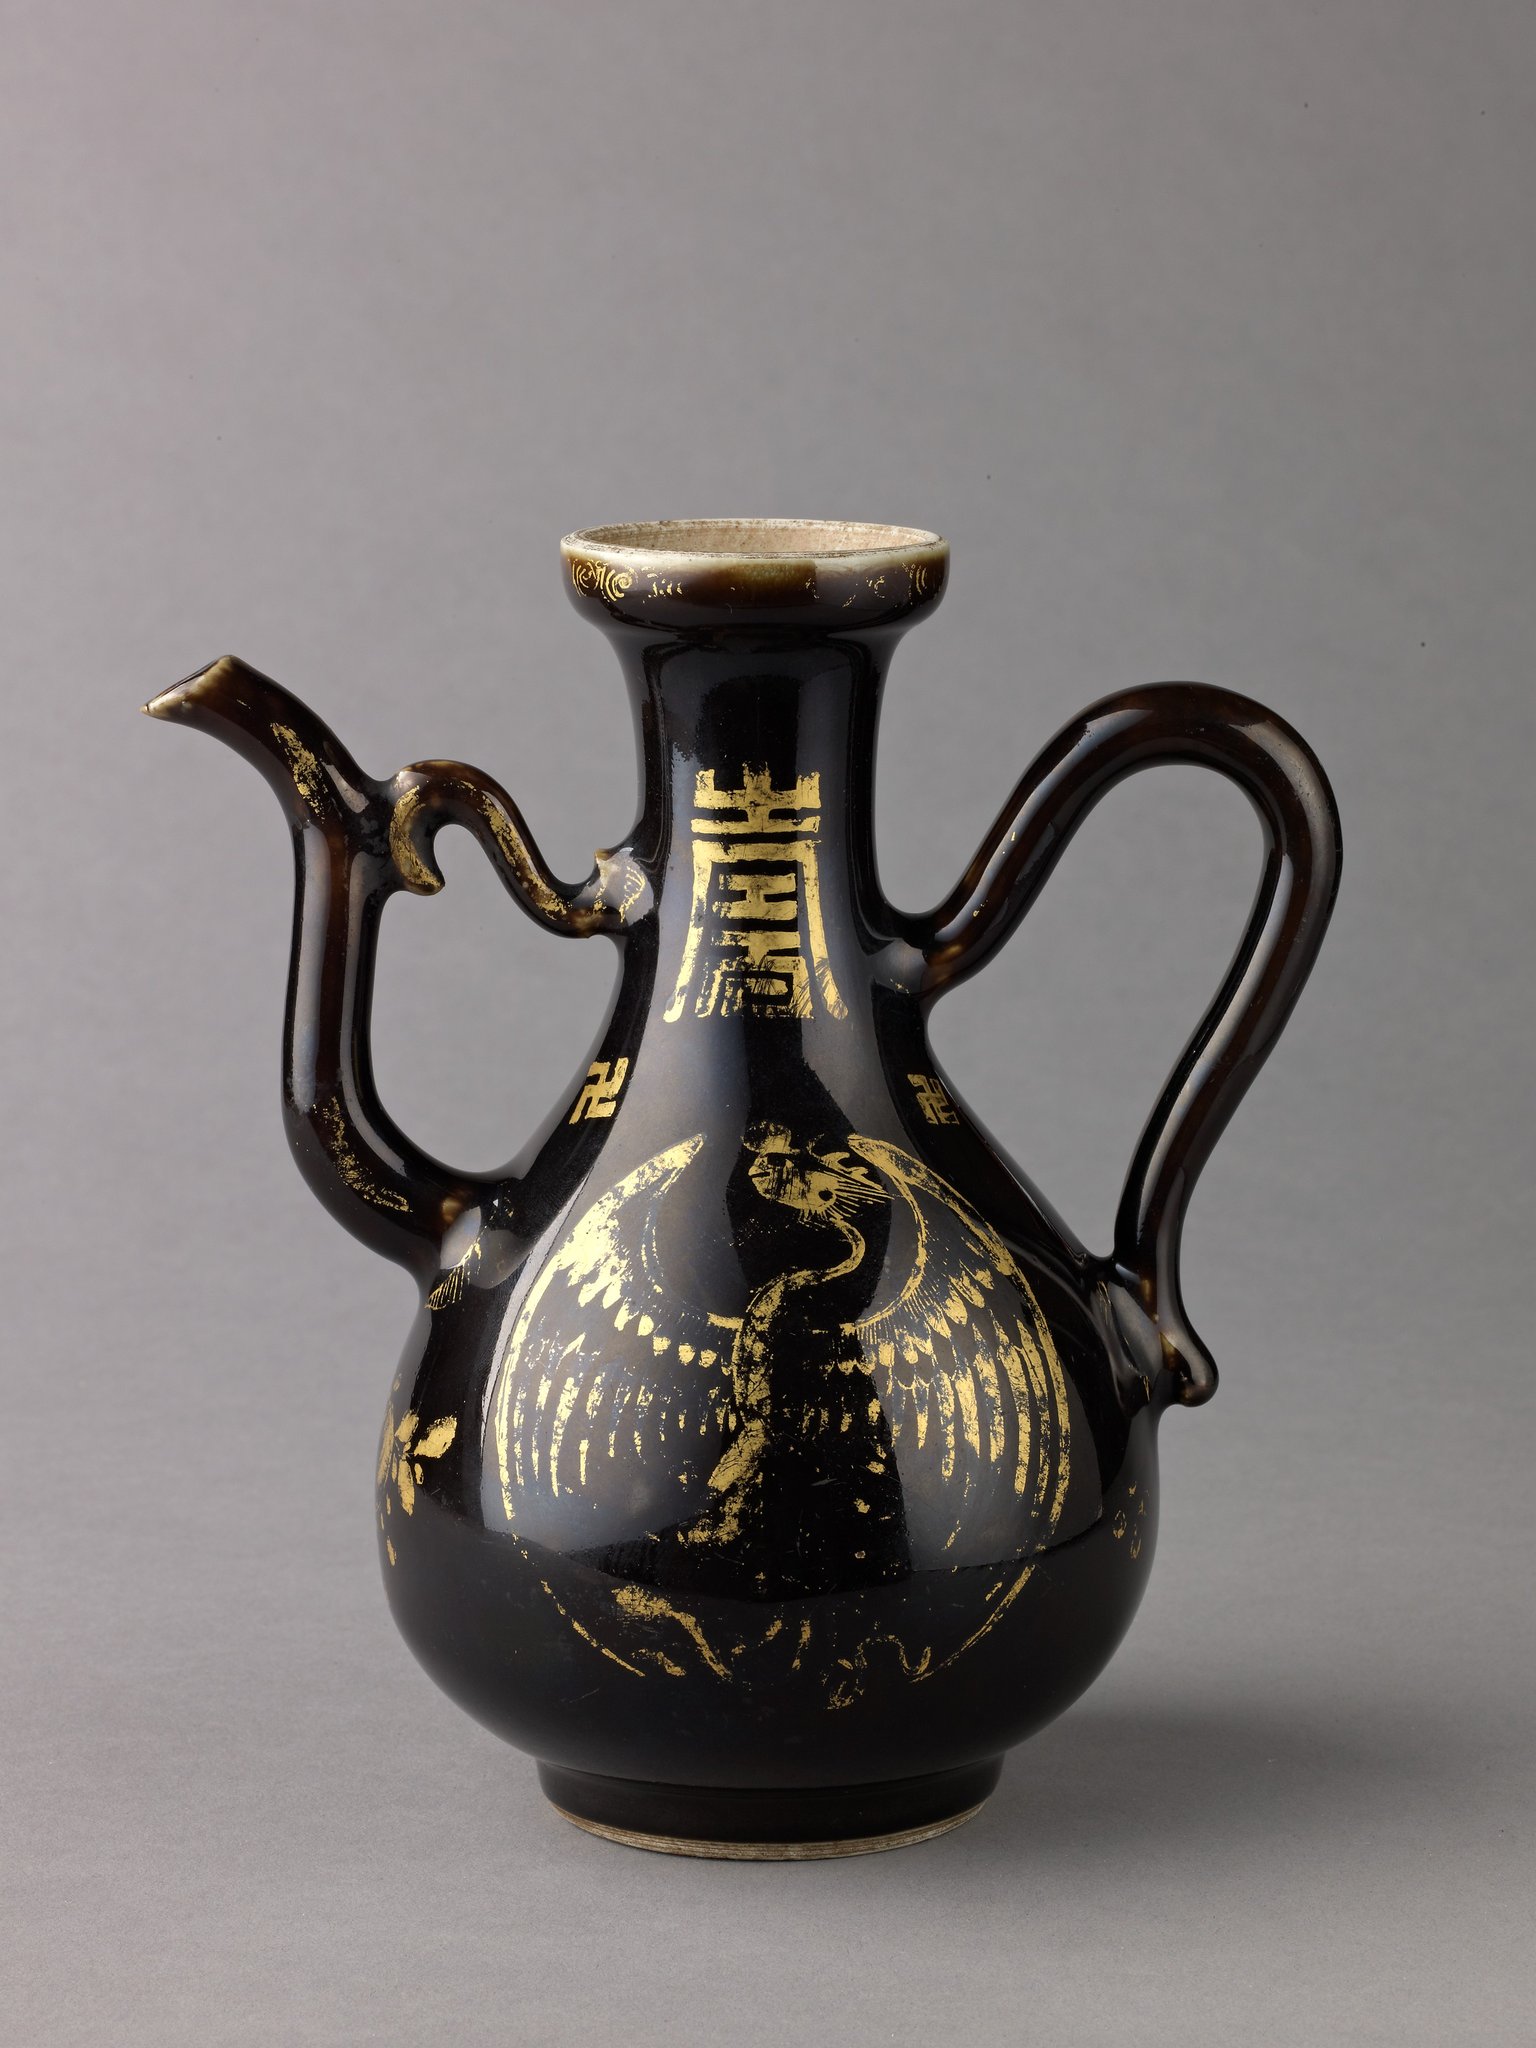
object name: ewer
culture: chinese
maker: chinese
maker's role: artist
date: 1662-1722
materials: gilt, glaze, porcelain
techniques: overglaze, painting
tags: phoenix